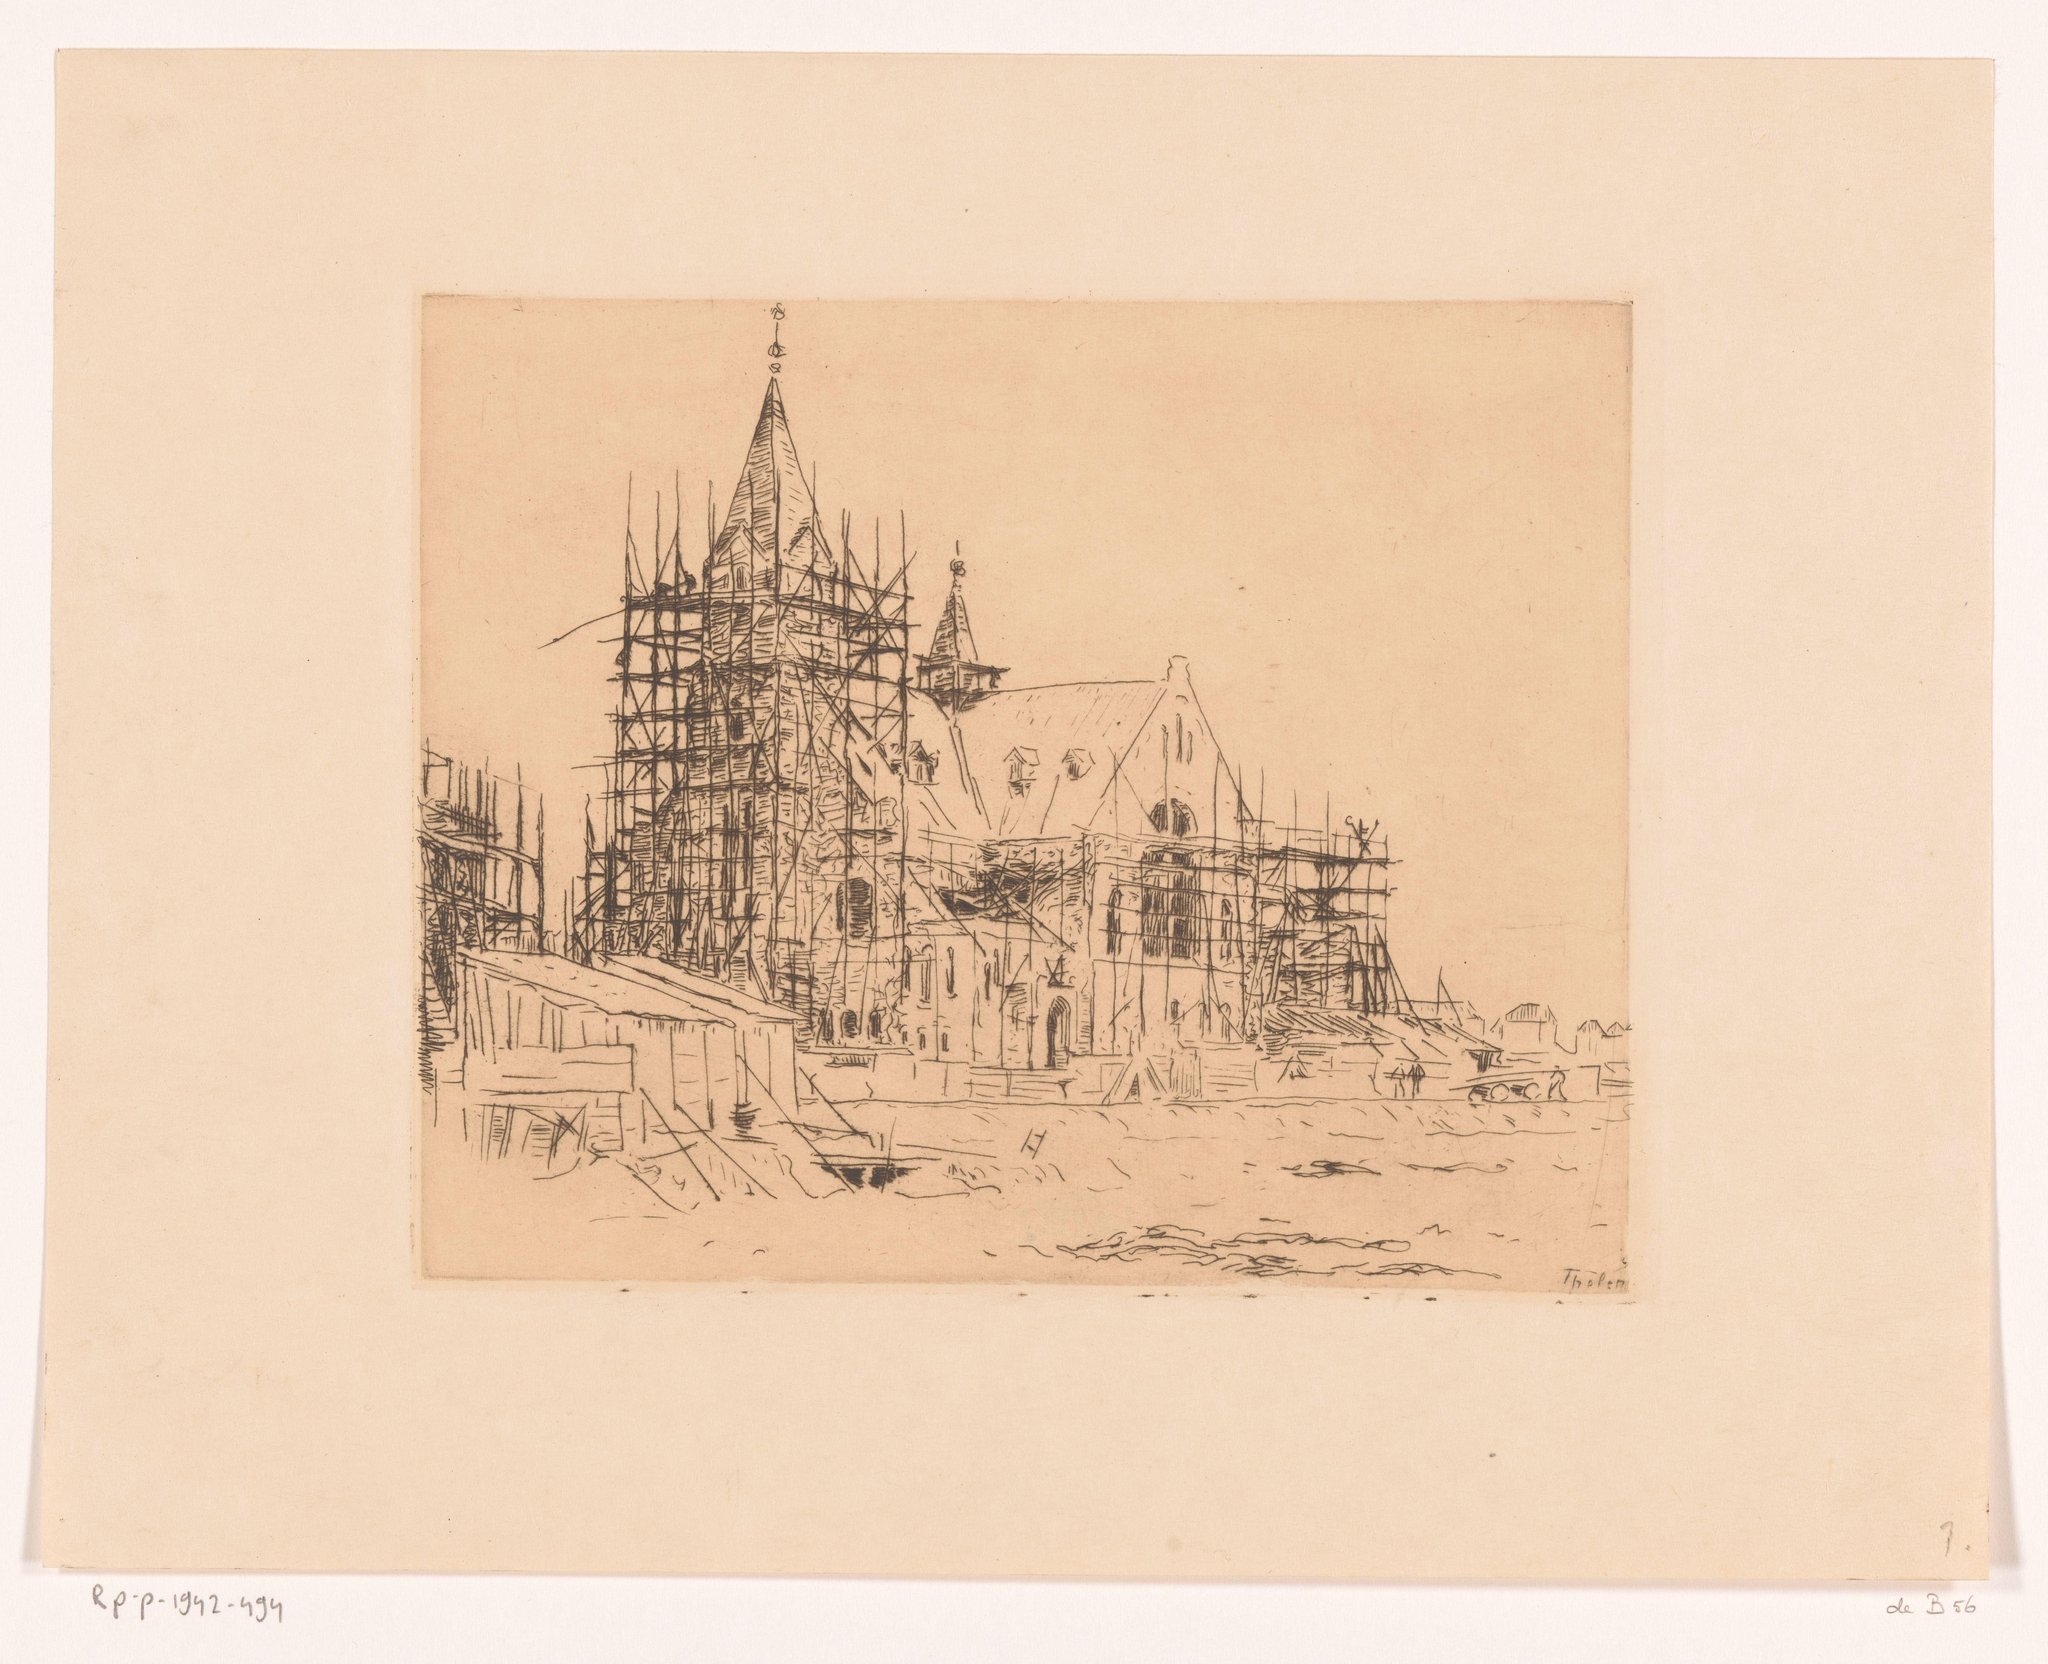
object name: print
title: Kerk in aanbouw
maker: willem bastiaan tholen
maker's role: draughtsman, painter, print maker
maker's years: 1860-1931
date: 1870-1914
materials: paper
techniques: etching, intaglio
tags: church (exterior), building-site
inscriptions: collector's mark: Lugt 2228